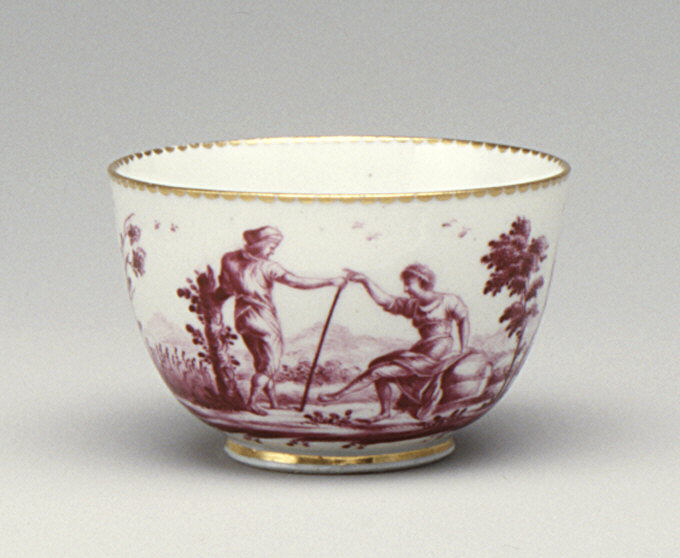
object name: cup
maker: doccia porcelain manufactory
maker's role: manufactory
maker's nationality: italian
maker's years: 1737-1896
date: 1770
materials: hard paste porcelain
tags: human figures